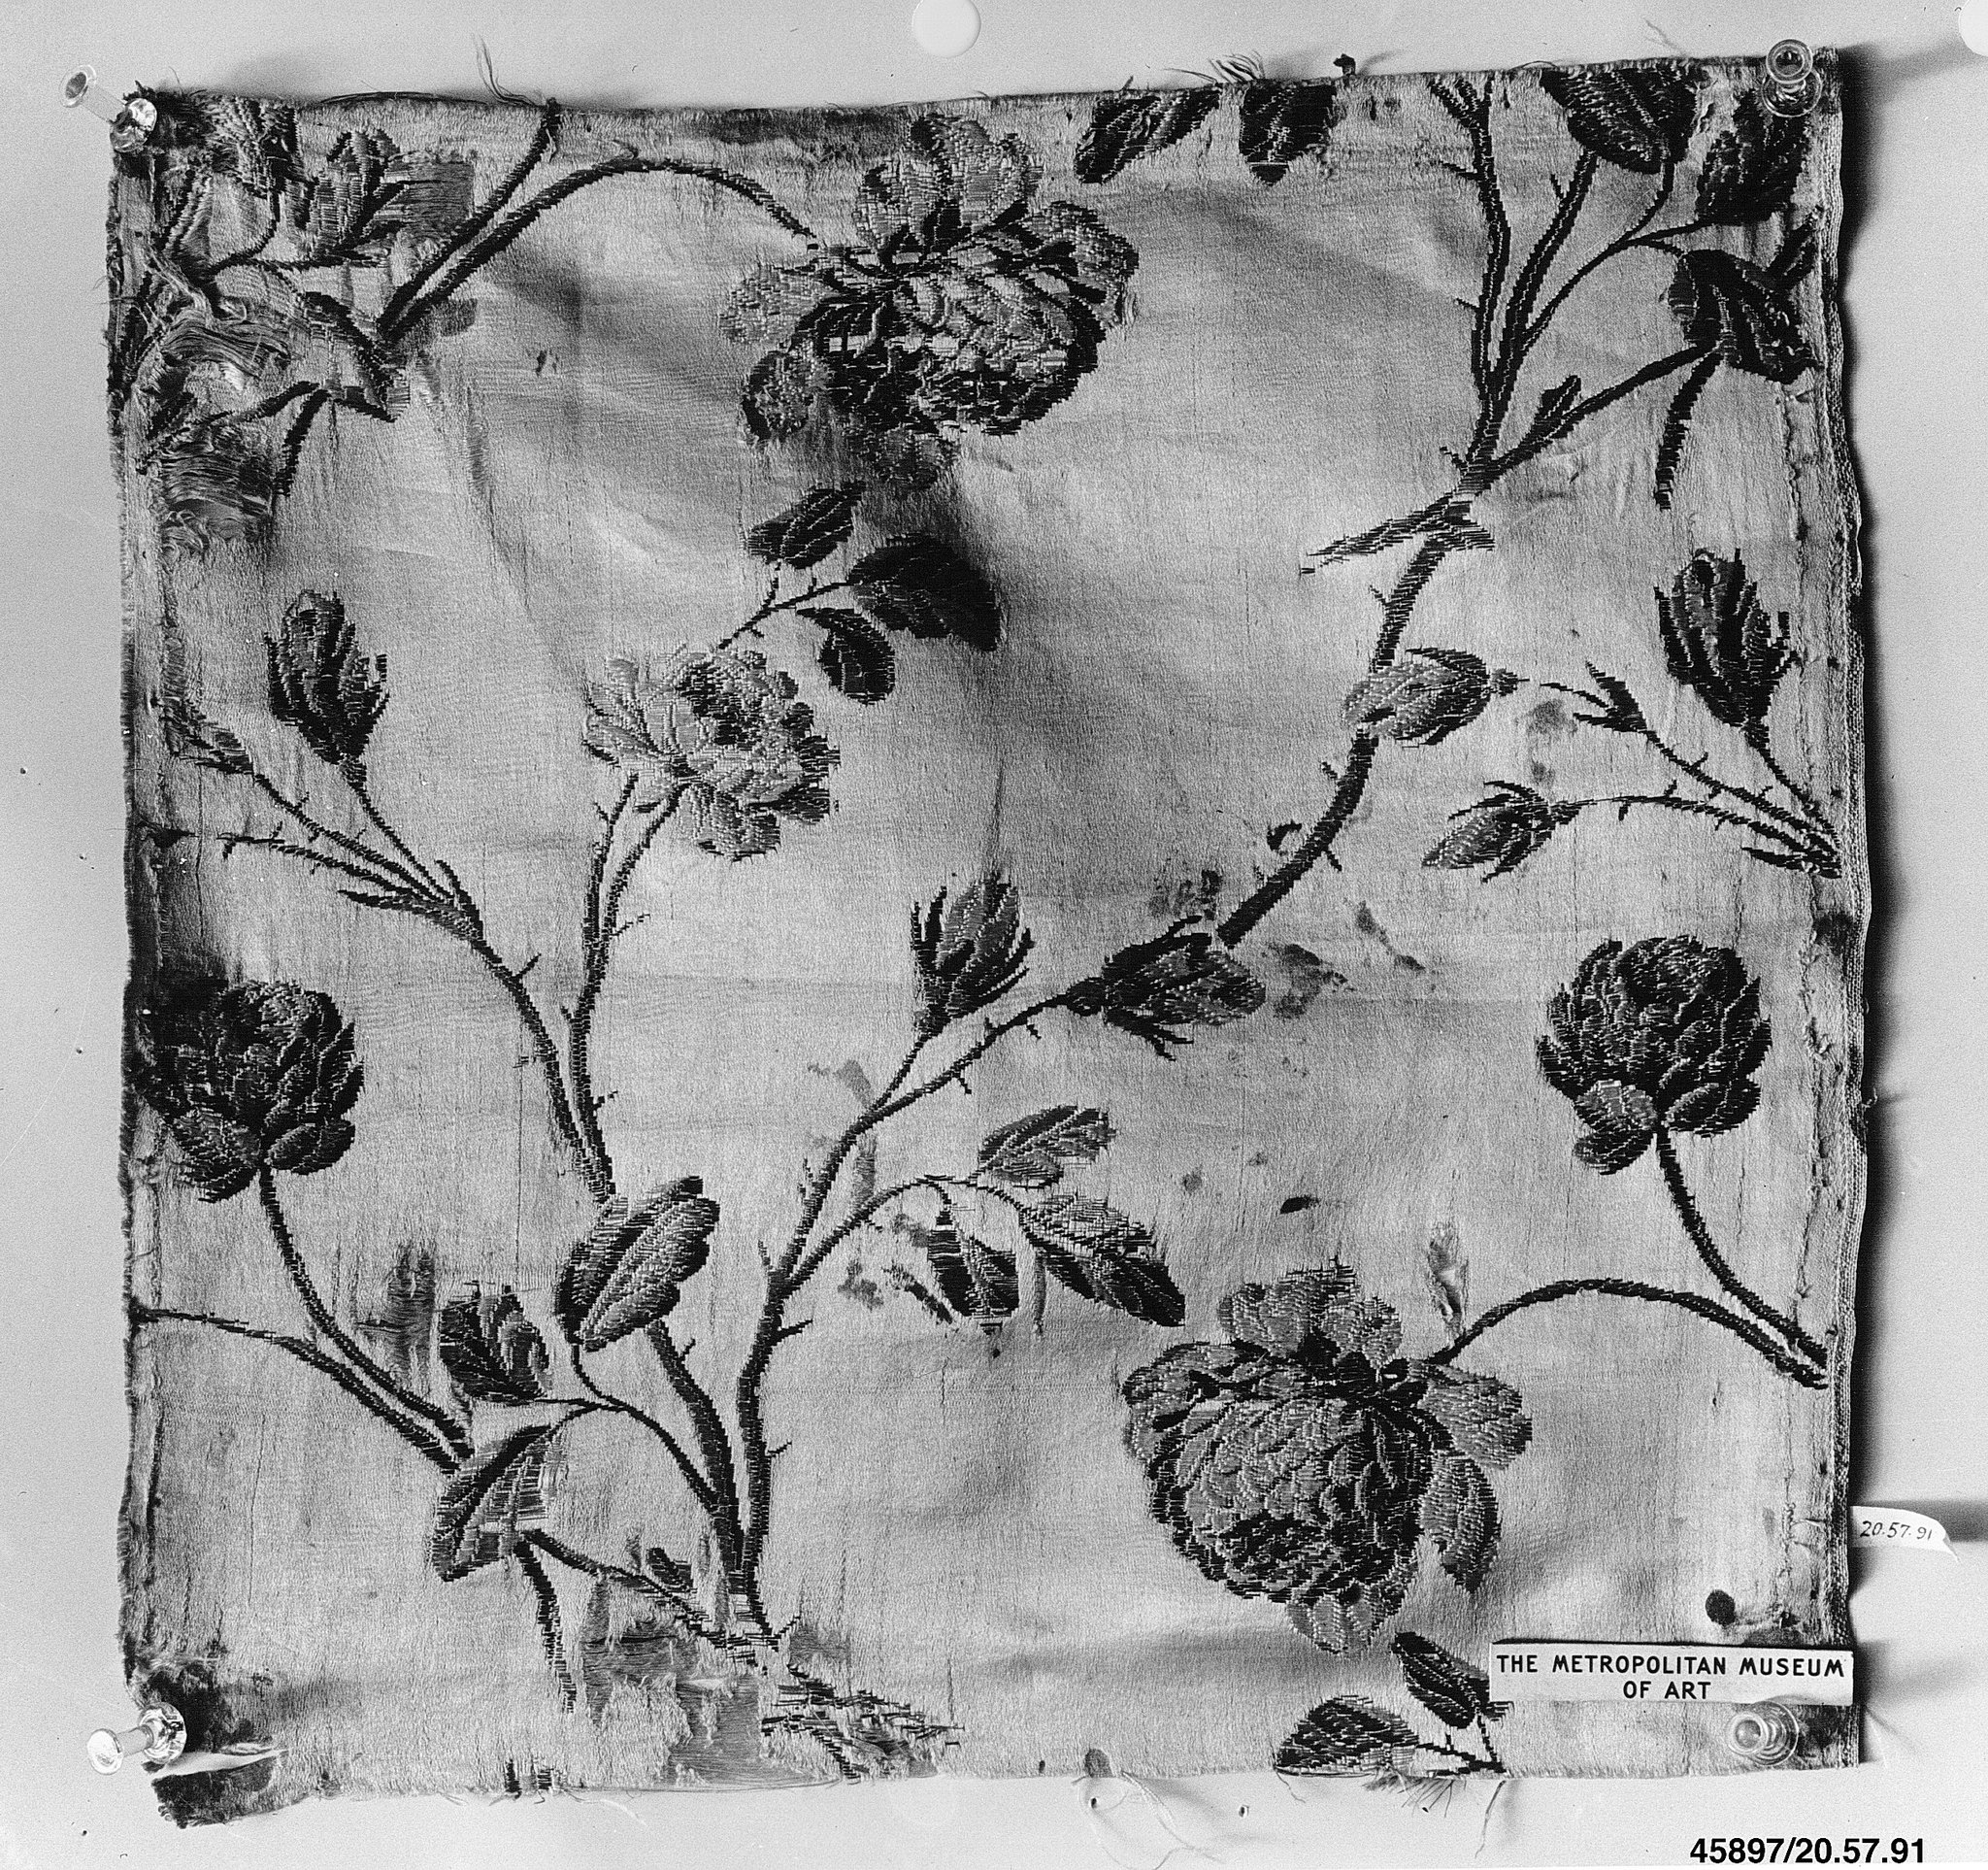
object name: piece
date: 1750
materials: silk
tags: flowers,leaves